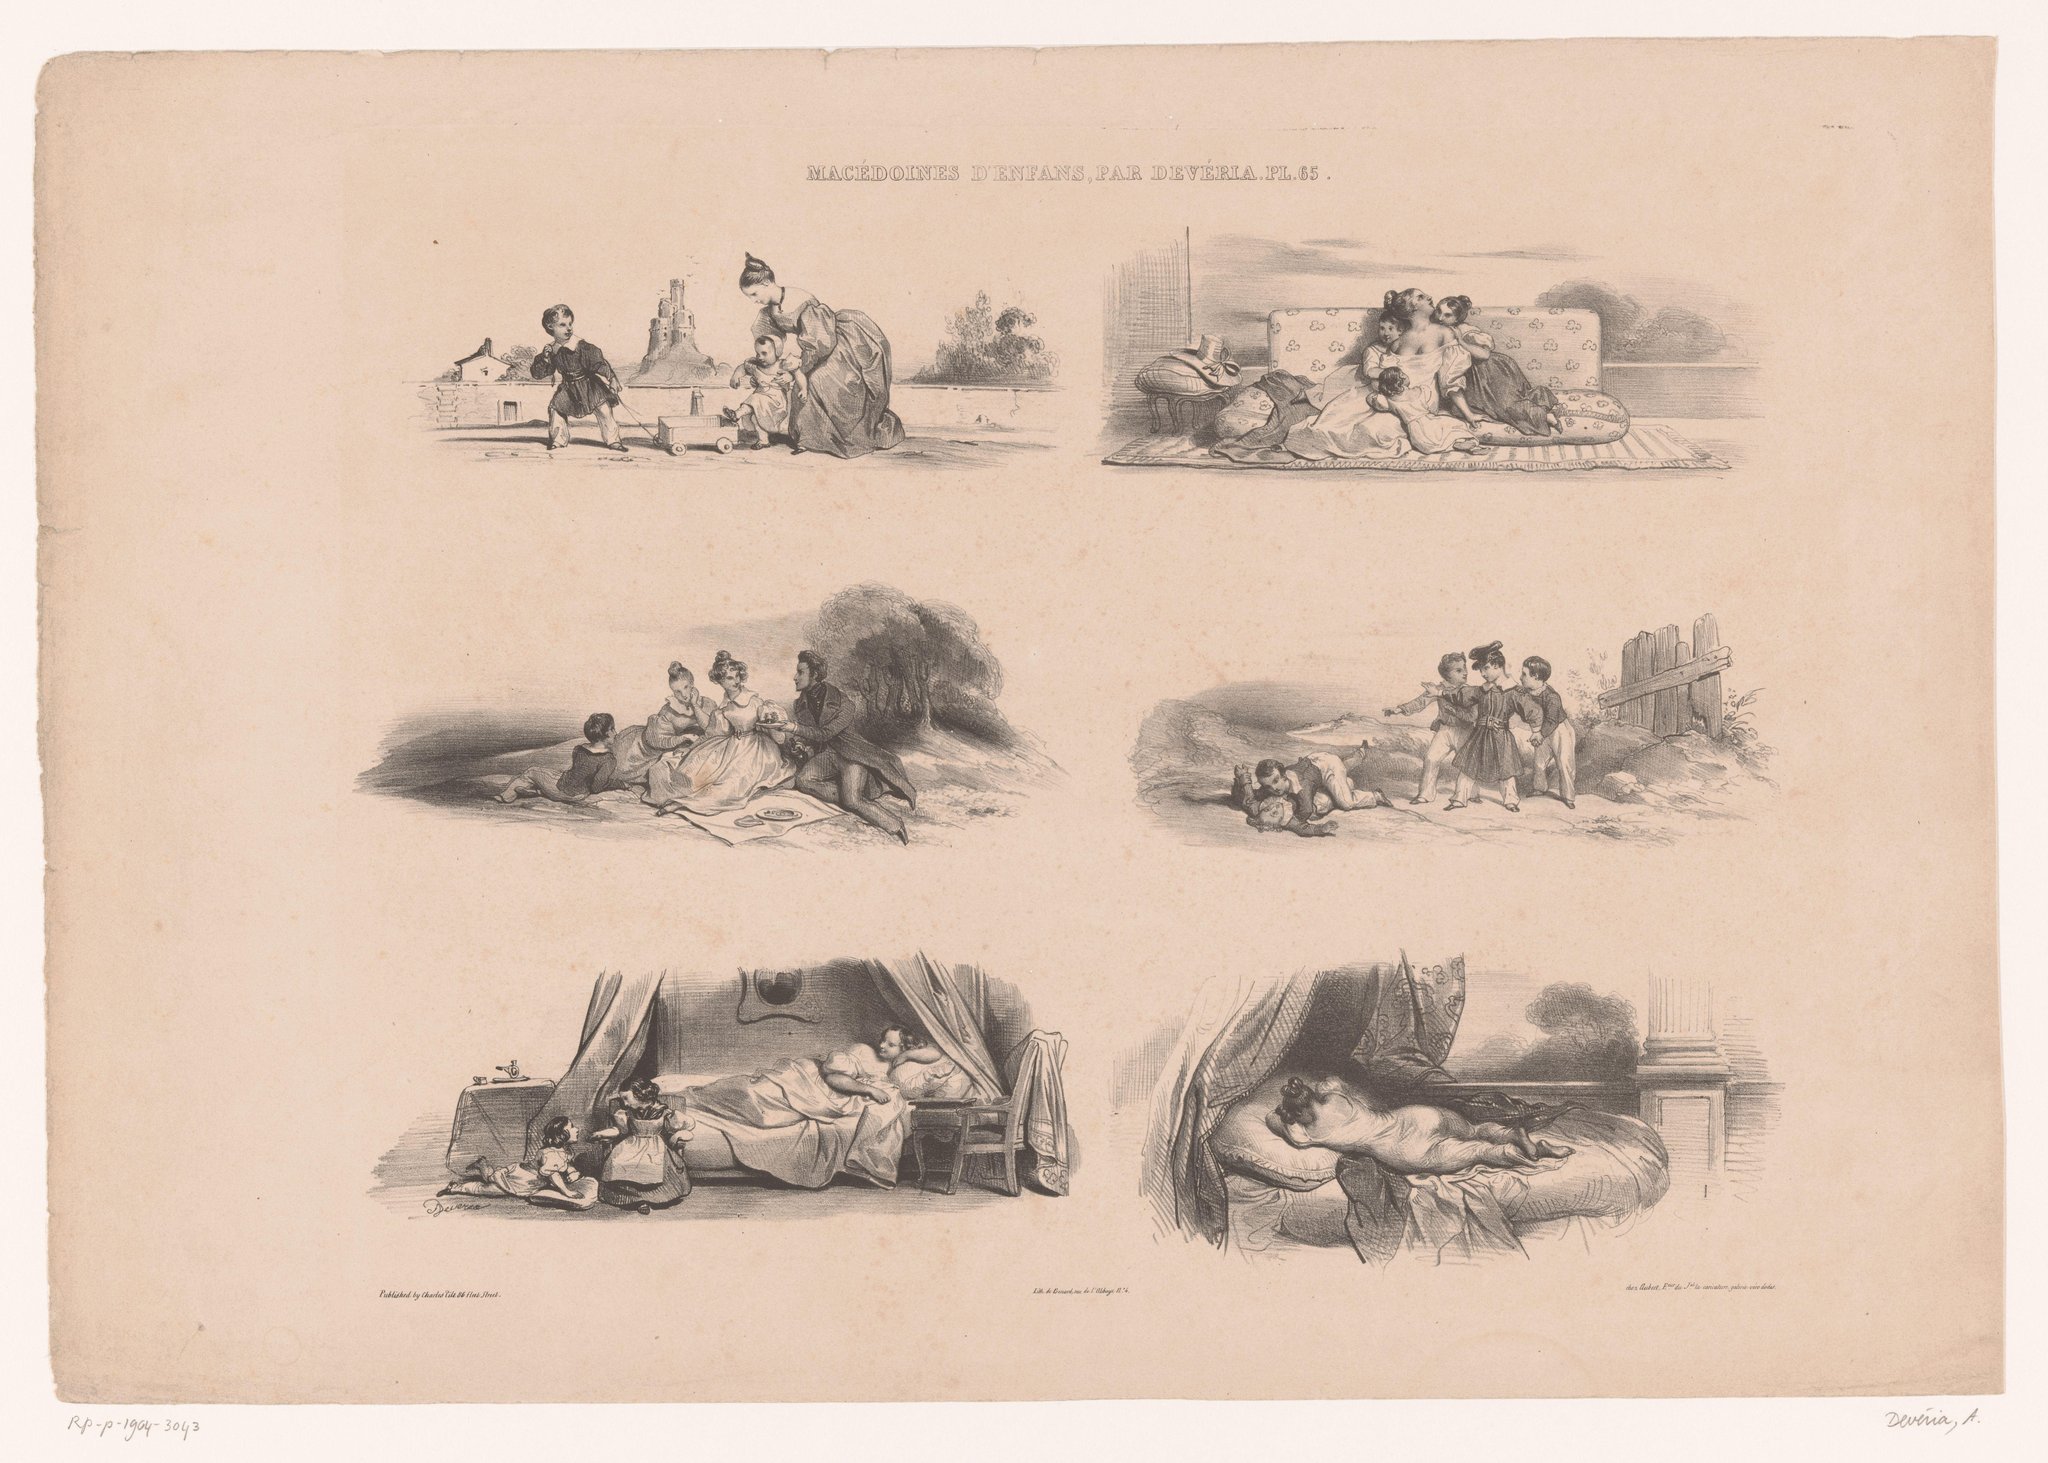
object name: print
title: Zes taferelen met kinderen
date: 1832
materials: paper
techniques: lithograph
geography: paris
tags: children's games and plays, picnic, alfresco, 'déjeuner sur l'herbe', mother and child(ren), woman and child(ren) (family group)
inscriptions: collector's mark: Lugt 2228a